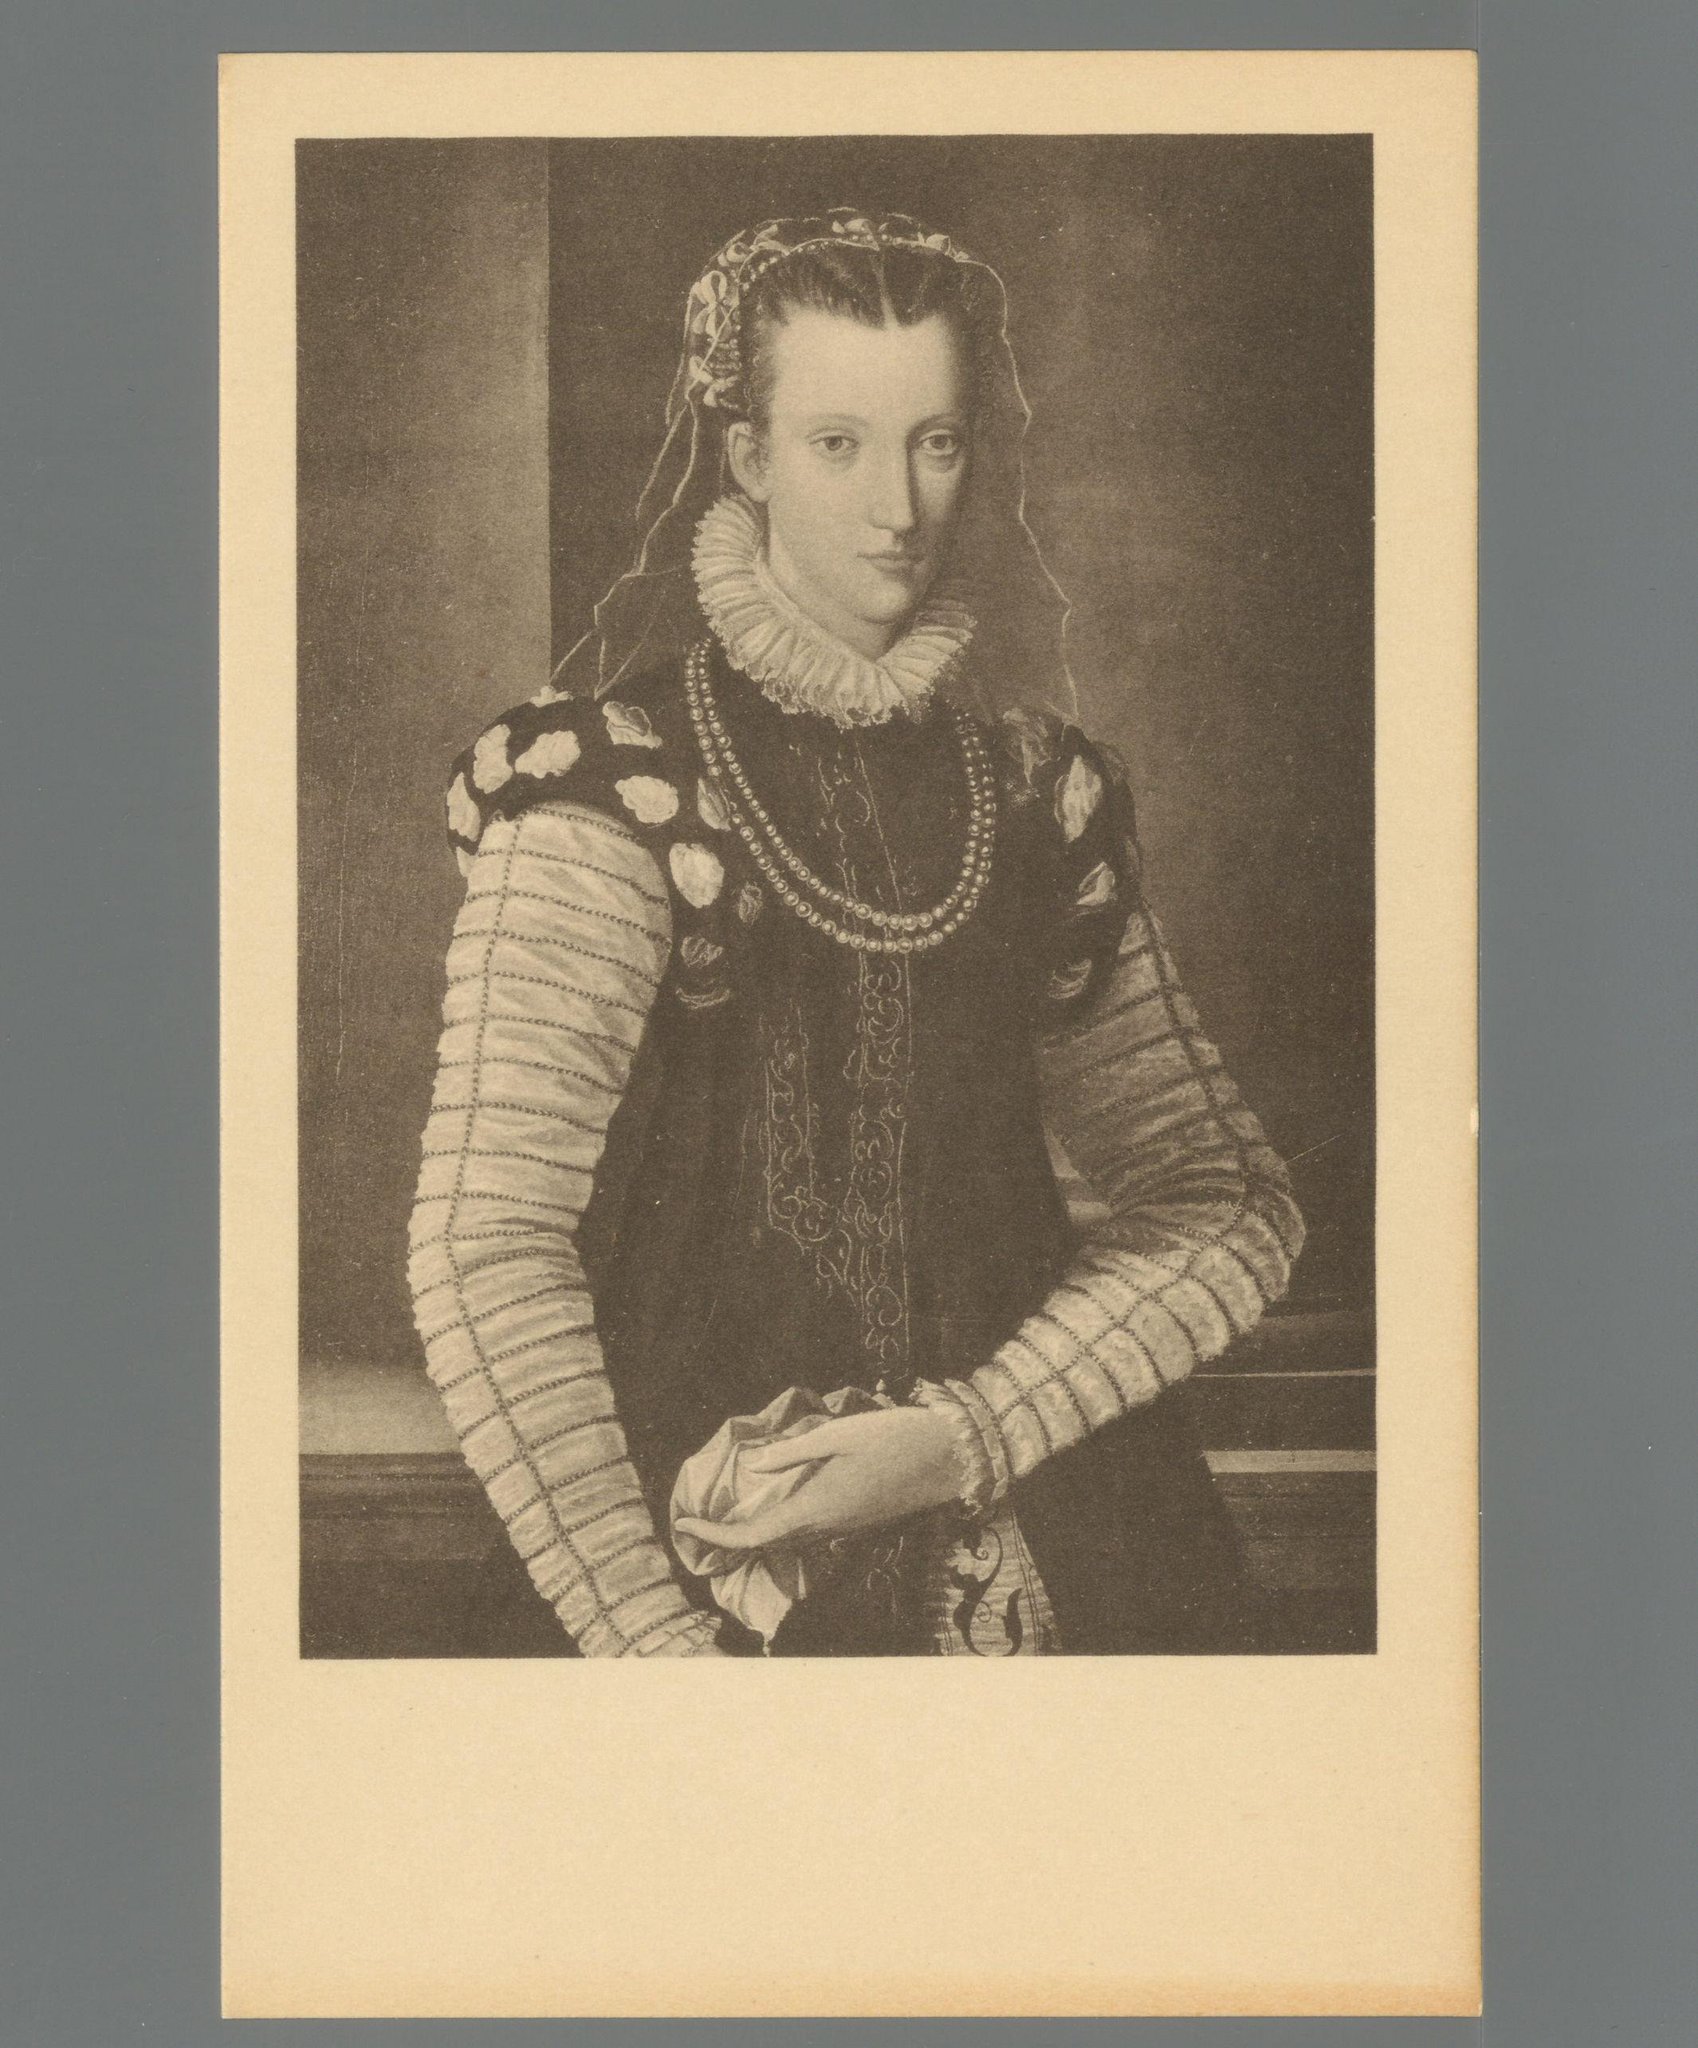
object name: photomechanical print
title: A Lady in Black and White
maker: Anonymous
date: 1903-1940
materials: cardboard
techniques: photograph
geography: boston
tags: historical persons not known by name